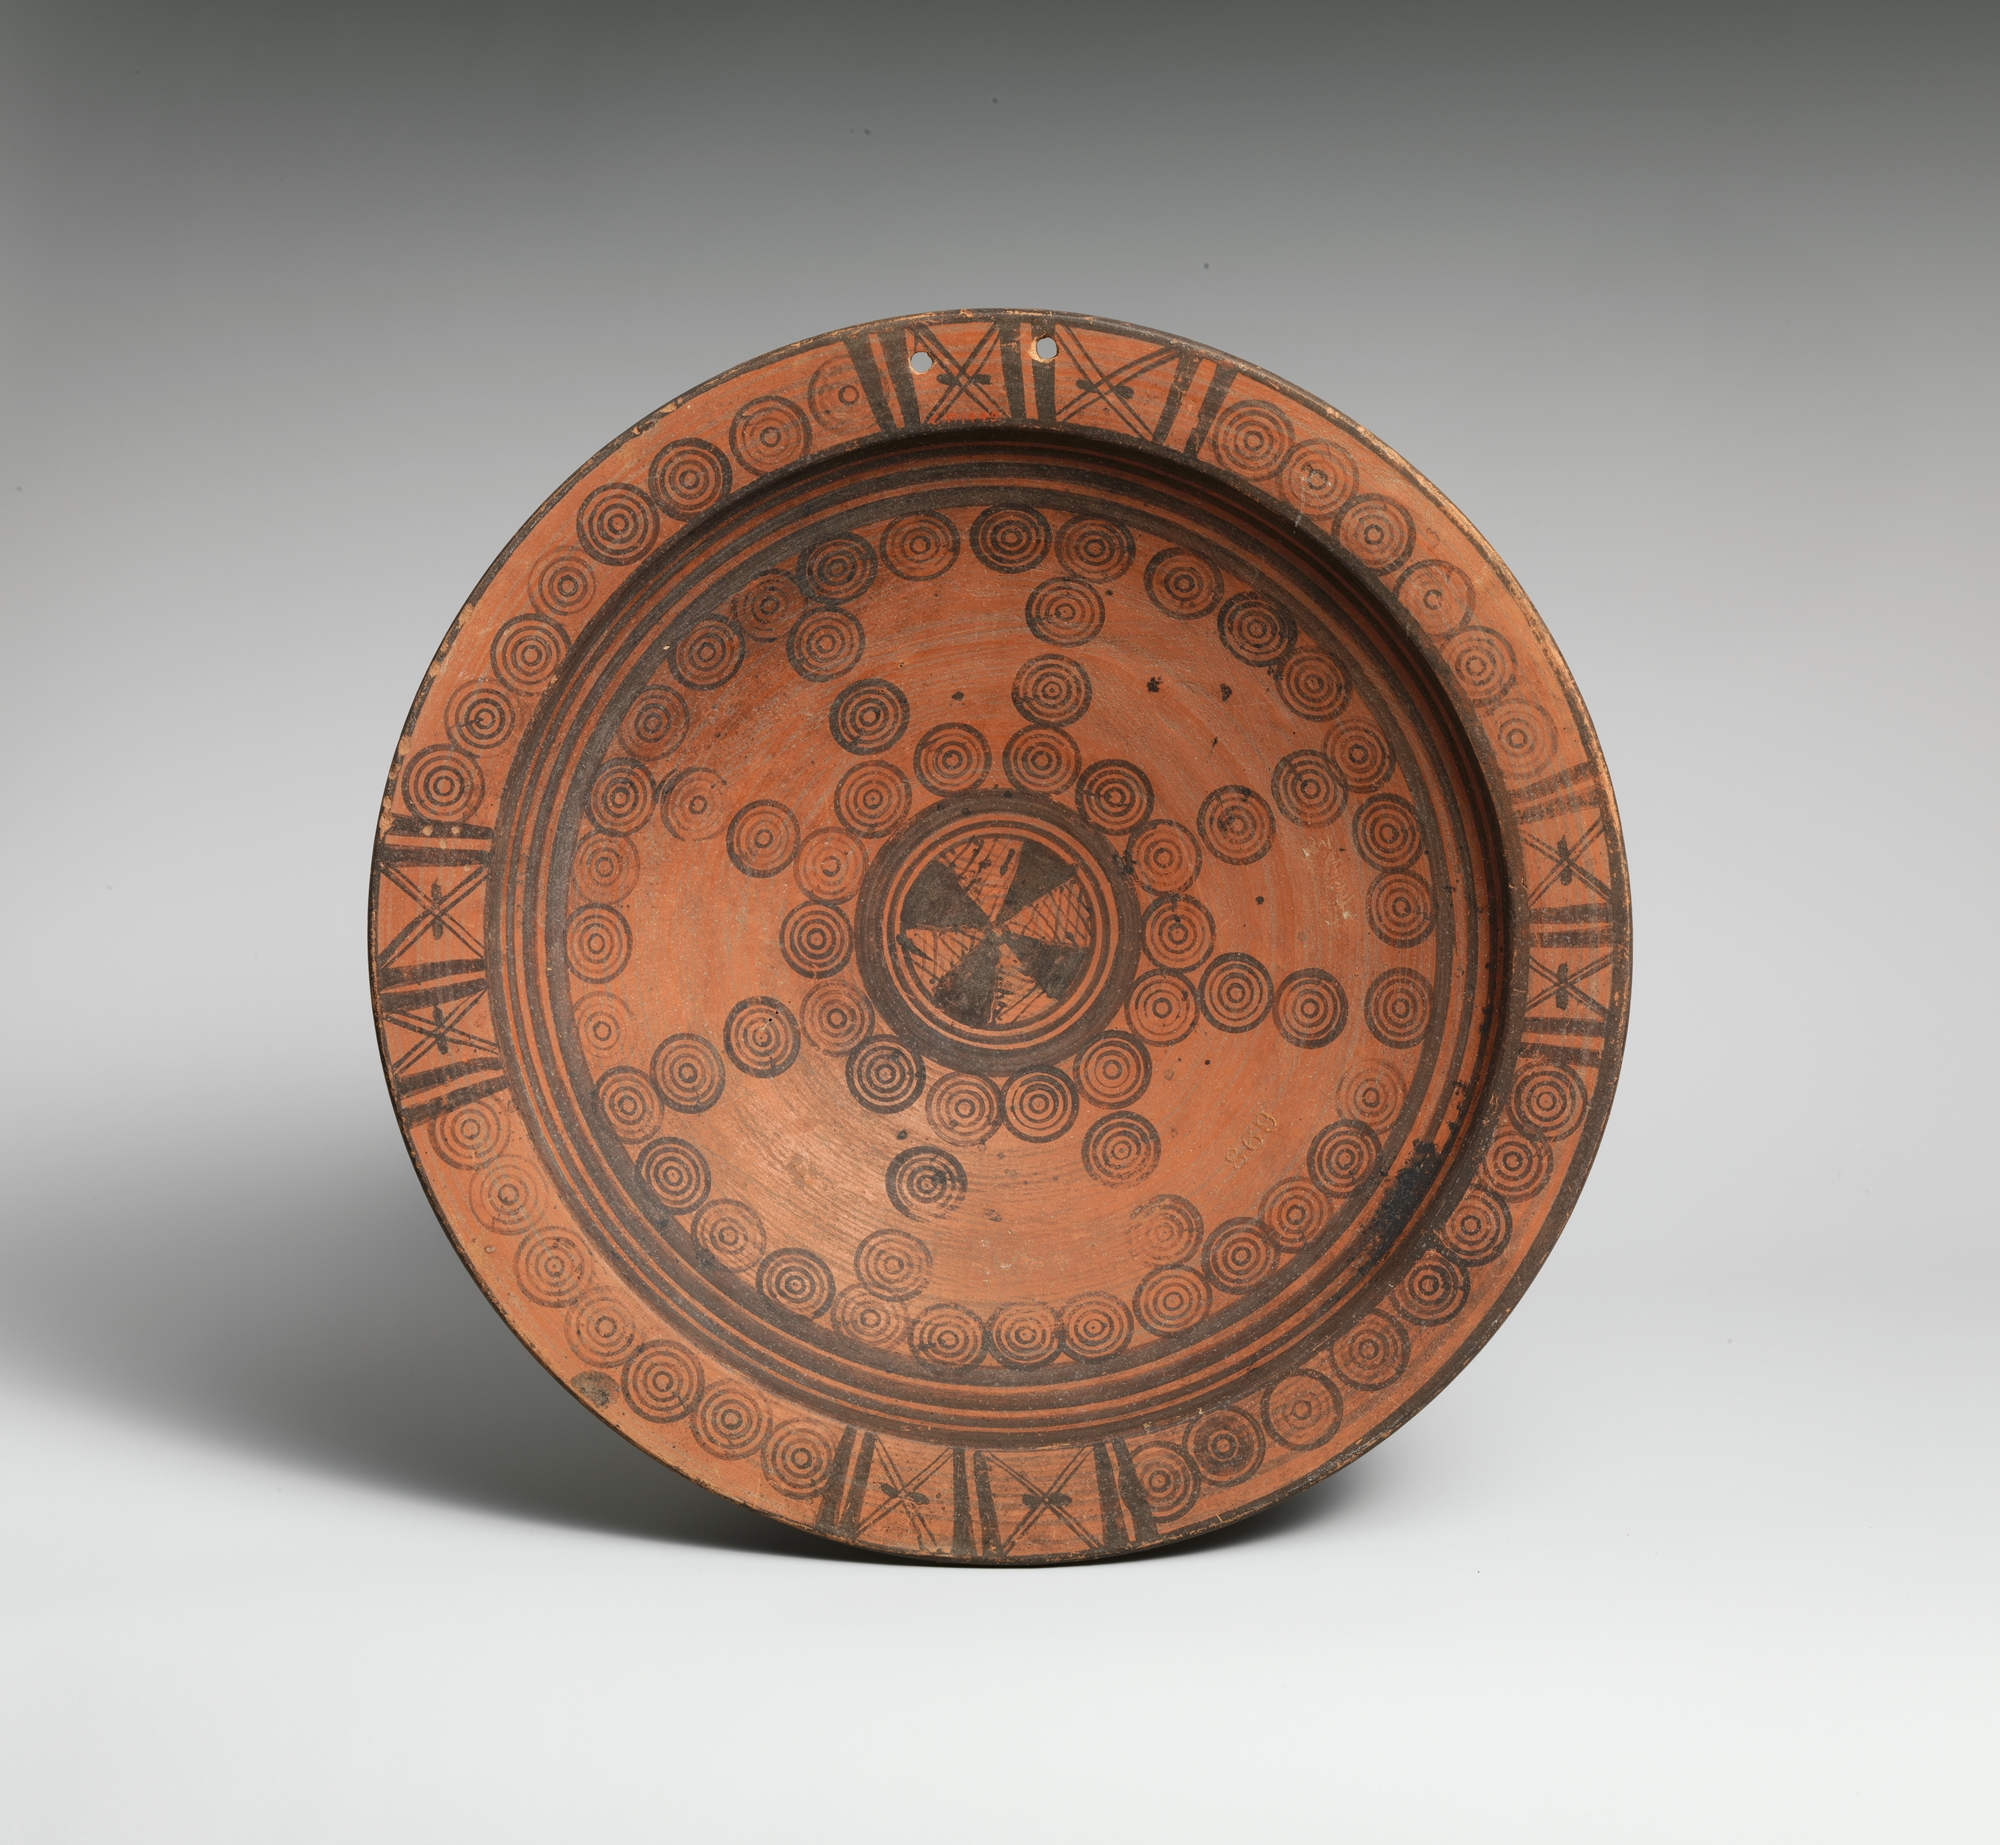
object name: plate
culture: cypriot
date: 750-600 BCE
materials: terracotta